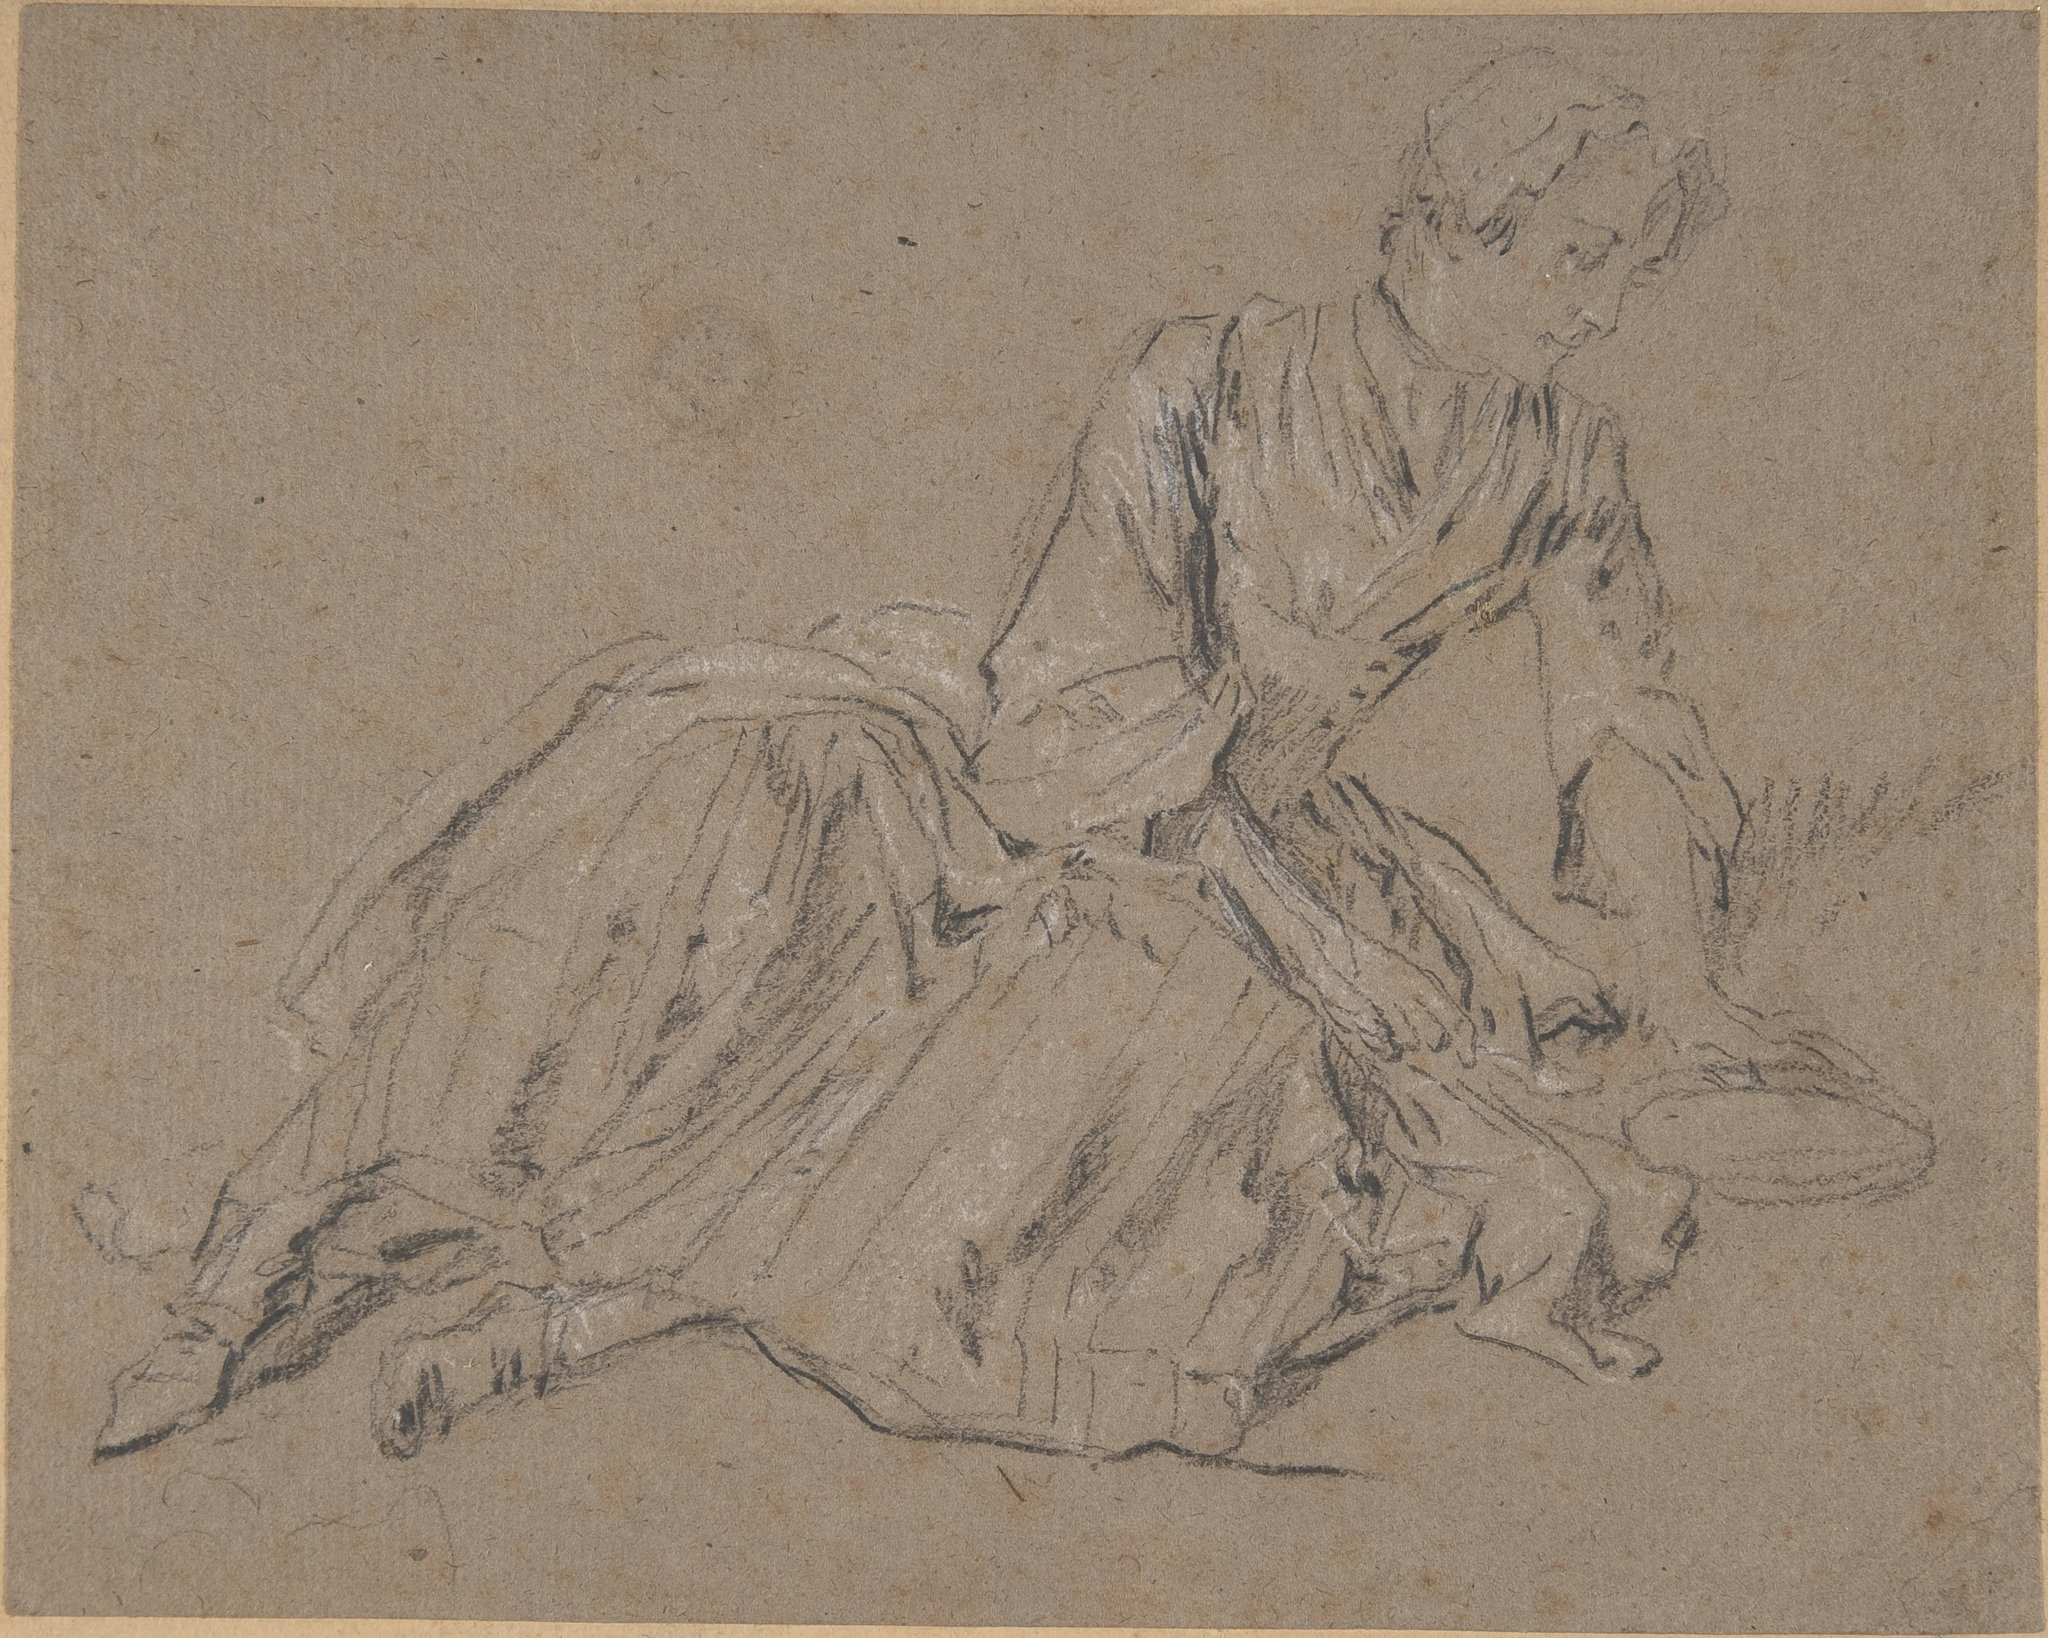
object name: drawing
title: Woman Seated on the Ground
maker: nicolas lancret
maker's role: artist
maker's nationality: french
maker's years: 1690-1743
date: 1701-1733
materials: chalk, paper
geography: france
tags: women